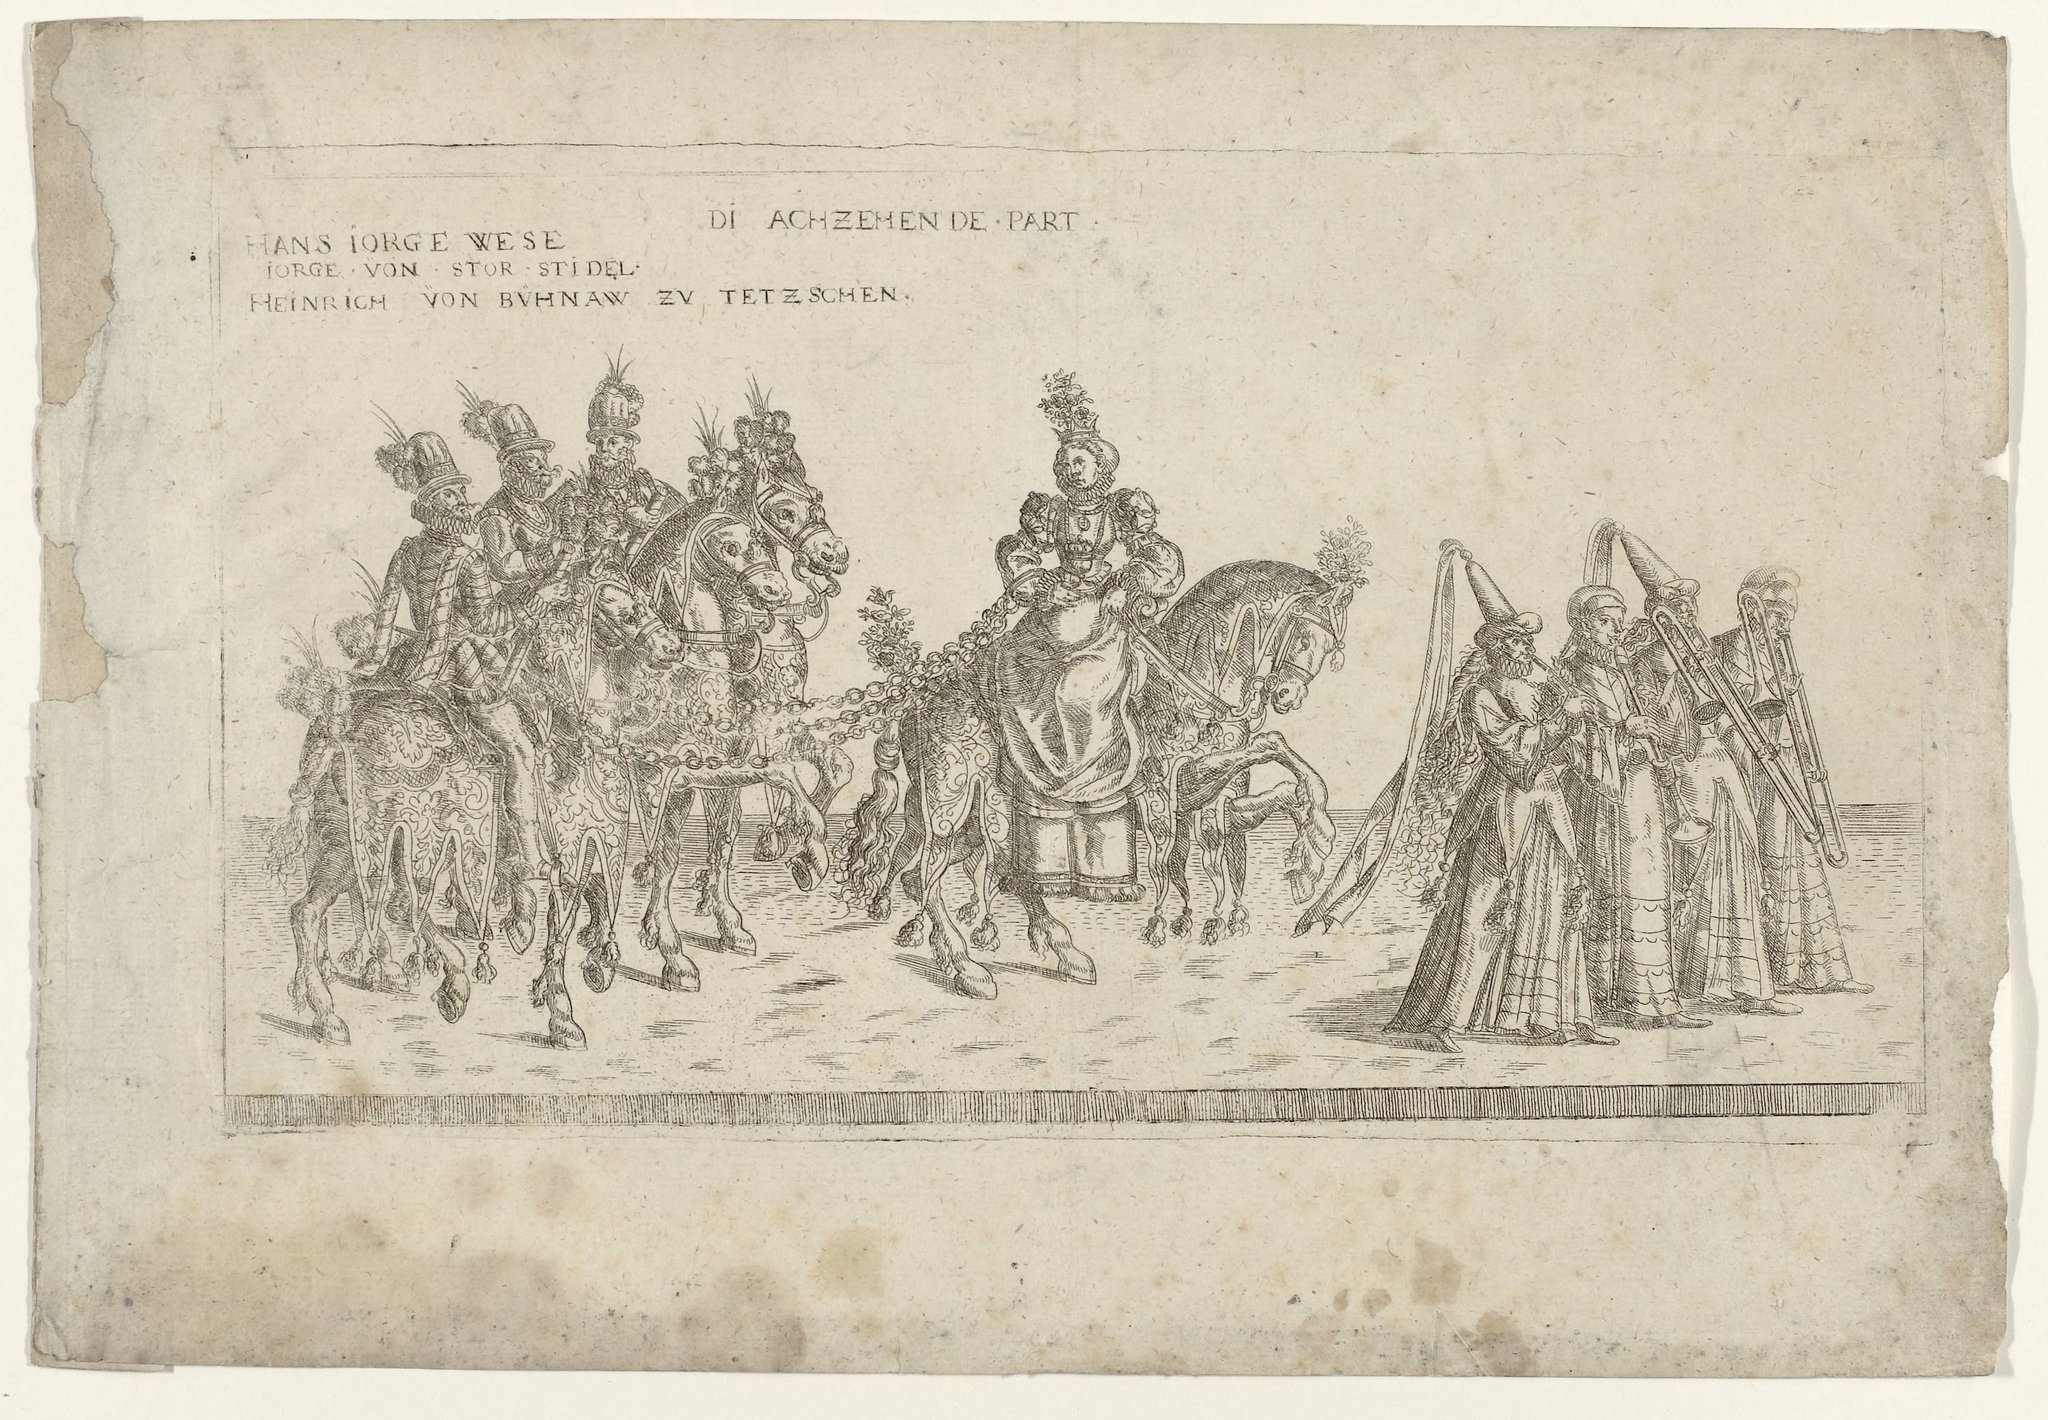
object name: print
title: Stoet met ruiters Hans Jorge Wese, Jorge von Storstidel en Heinrich von Buhnaw zu Tetzschen, geketend aan een gekroonde vrouw te paard en voorafgegaan door vier muzikanten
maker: Anonymous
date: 1553-1586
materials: paper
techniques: etching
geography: germany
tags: riding a horse, ass, or mule; rider, horseman, dress-up party, rejoicing on special occasions (+ parade, pageant, cavalcade ~ festive activities), more than one musician with instrument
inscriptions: collector's mark: Lugt 2228, collector's mark: Lugt 2760